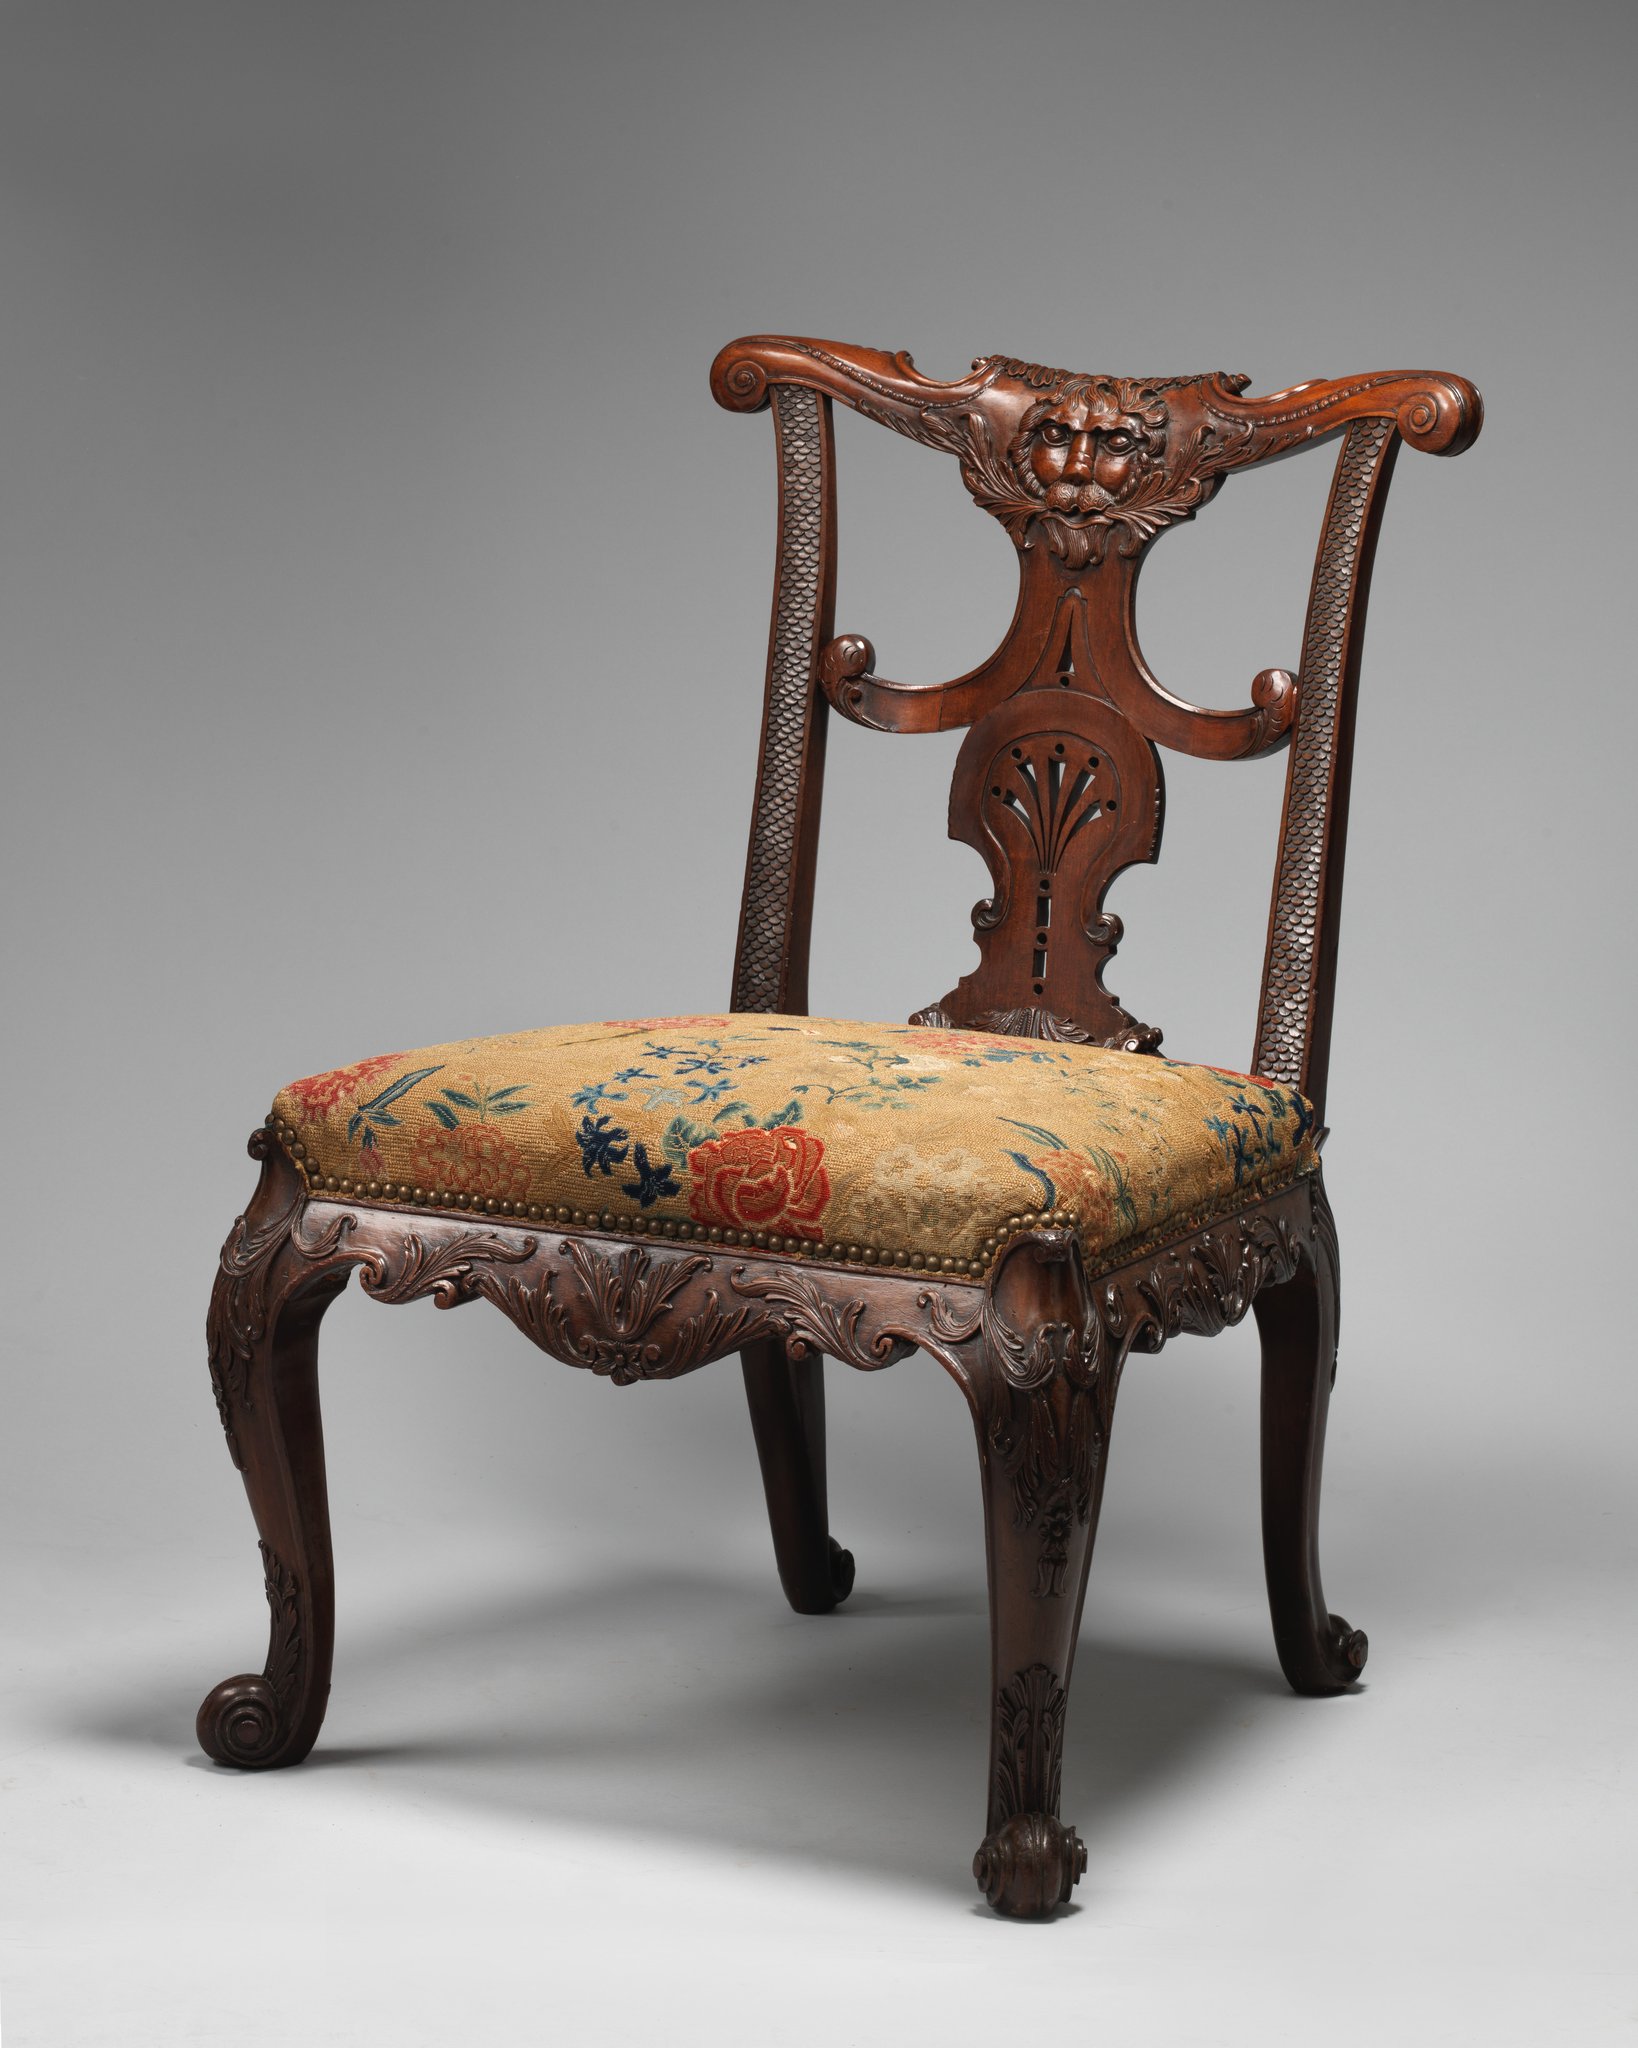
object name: side chair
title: Side chair (one of a pair)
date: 1735-1740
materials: wood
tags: faces